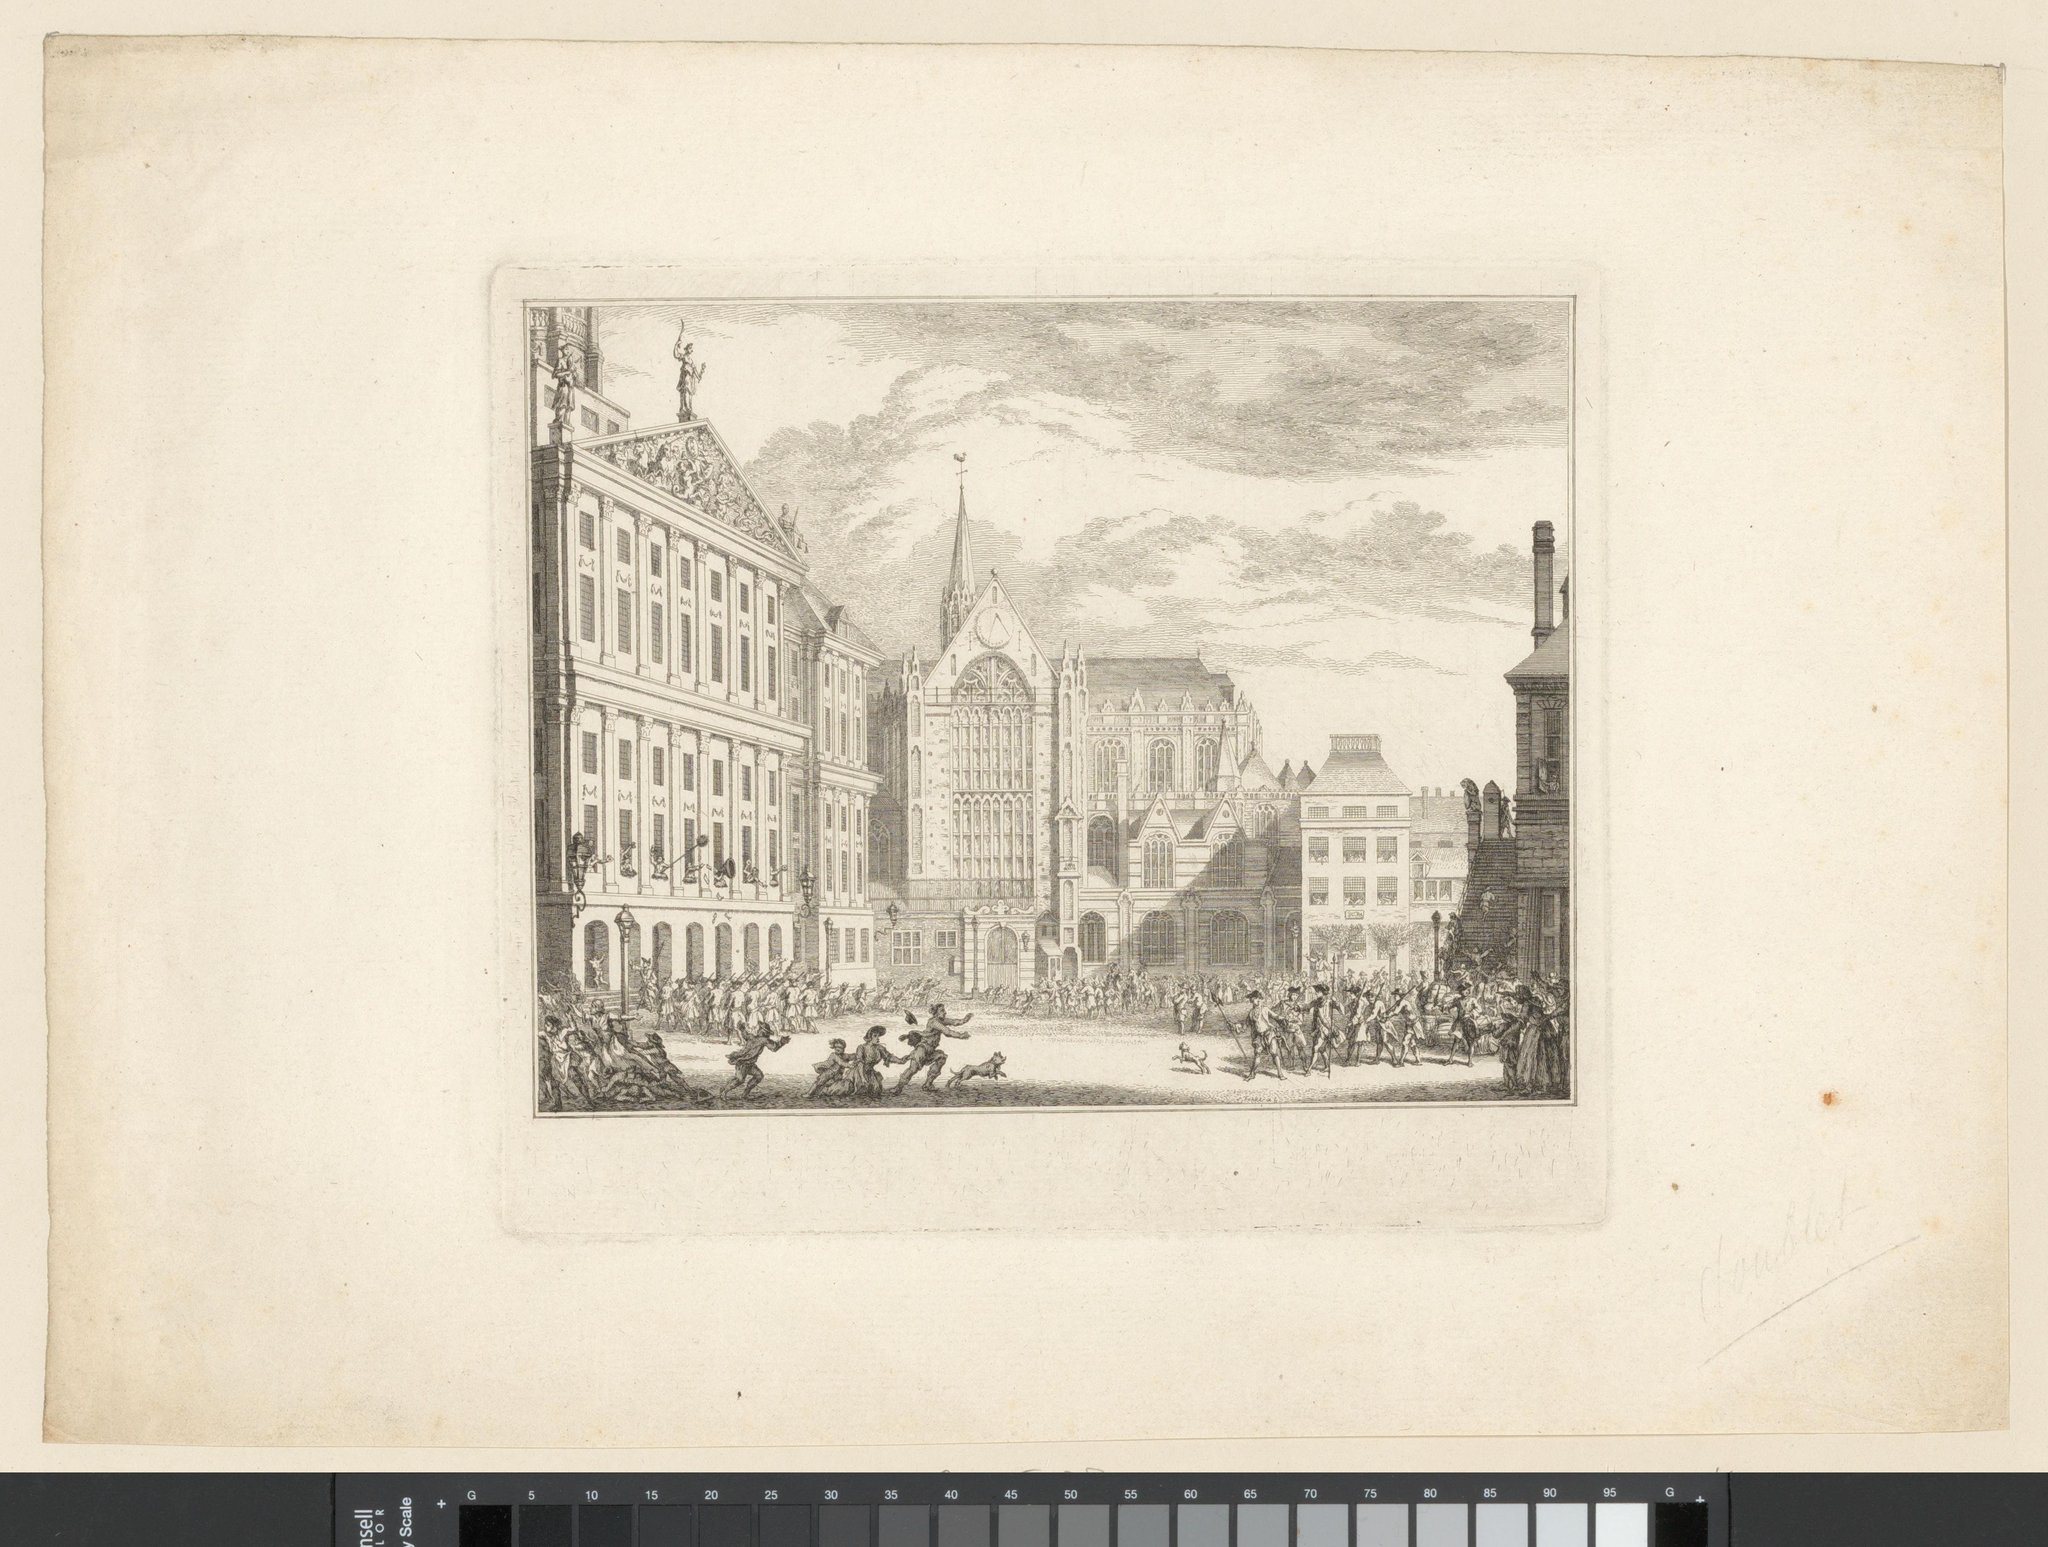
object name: print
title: Capt. Scheerenberg stilt het oproer op den Dam te Amsterdam ao. 1747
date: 1782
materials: paper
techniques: etching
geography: amsterdam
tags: church (exterior), townhall, street-fights, riots, strike (political demonstration)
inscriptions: stamp, stamp, collector's mark: Lugt 1641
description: Onder leiding van kapitein Abraham Scheerenberg worden Oranjegezinde oproerkraaiers, aangevoerd door Daniël Raap, verjaagd uit het stadhuis en van de Dam op 9 november 1747. In het bezette stadhuis steekt een demonstrant een ragebol uit het raam, wat een spottende verwijzing is naar de door de schout gedragen roede. In het midden de Nieuwe Kerk en rechts een deel van de Waag. Onderwerpsrubrieken binnen de Atlas Zeden en Gewoonten: Krijgswezen, Schutterij, Historieprenten.